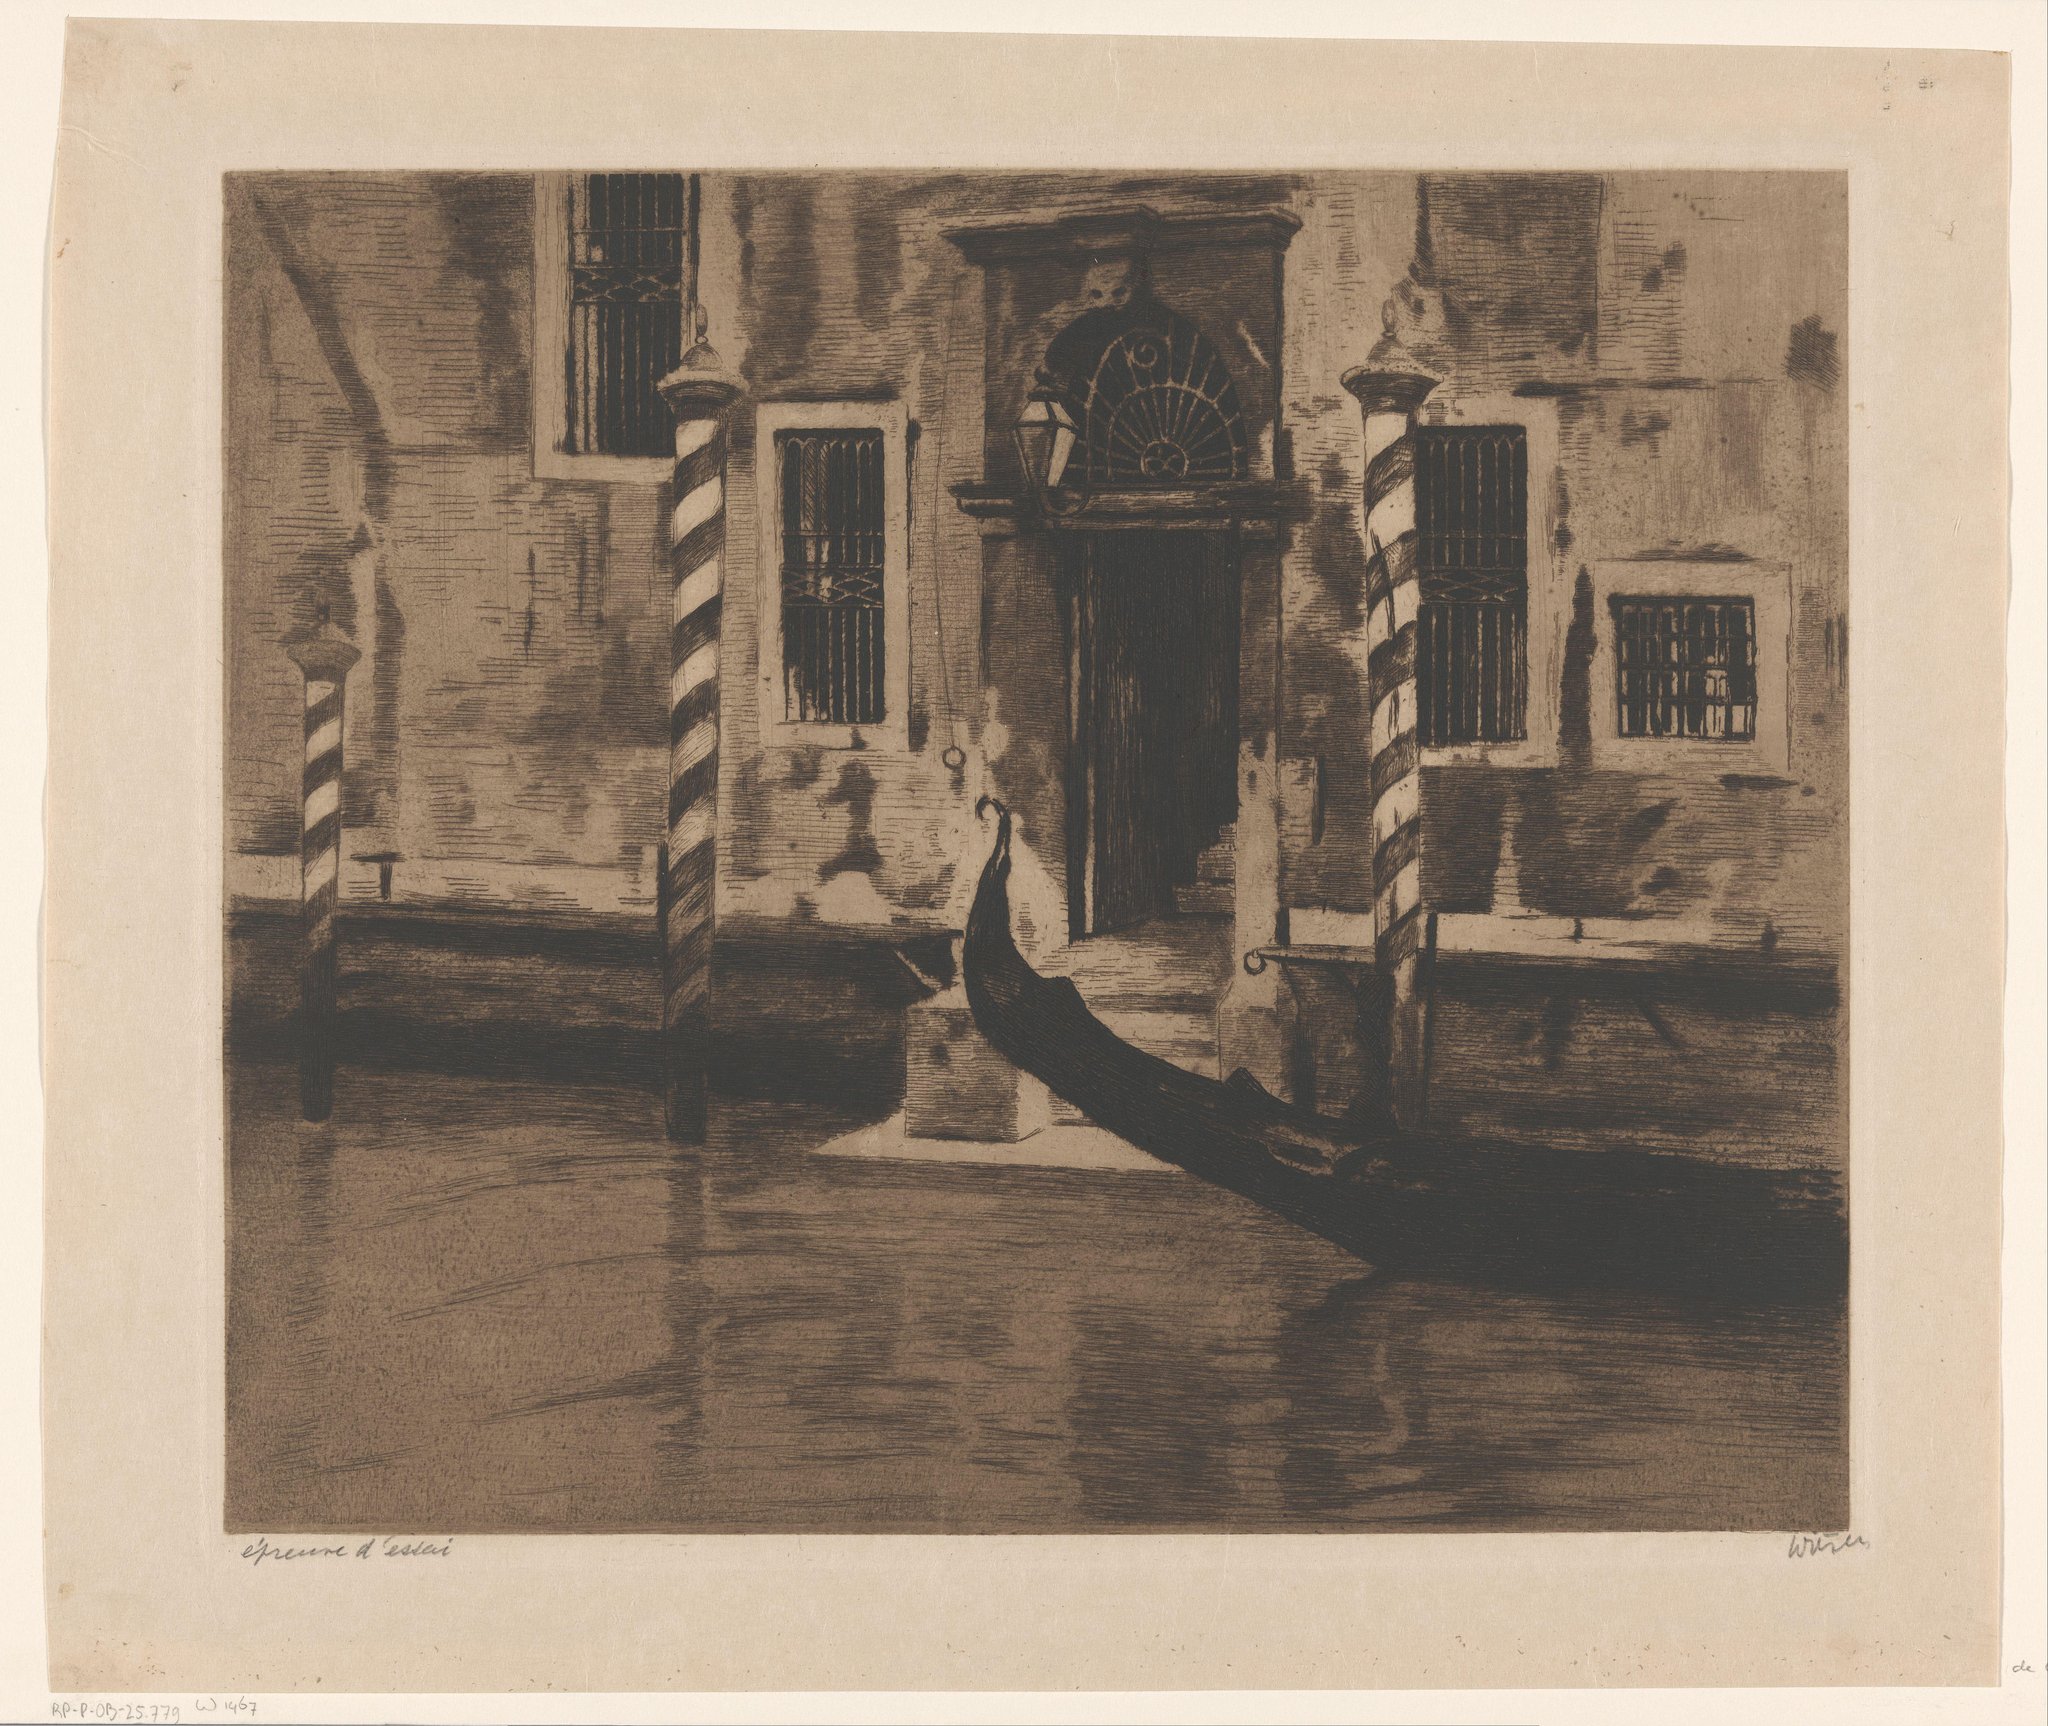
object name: print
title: Gondel in het Canal Grande in Venetië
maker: willem witsen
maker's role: draughtsman, painter, print maker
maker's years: 1860-1923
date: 1914-1919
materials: paper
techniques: aquatint, etching, intaglio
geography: amsterdam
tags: gate, entrance, canals, waters (in city), gondola